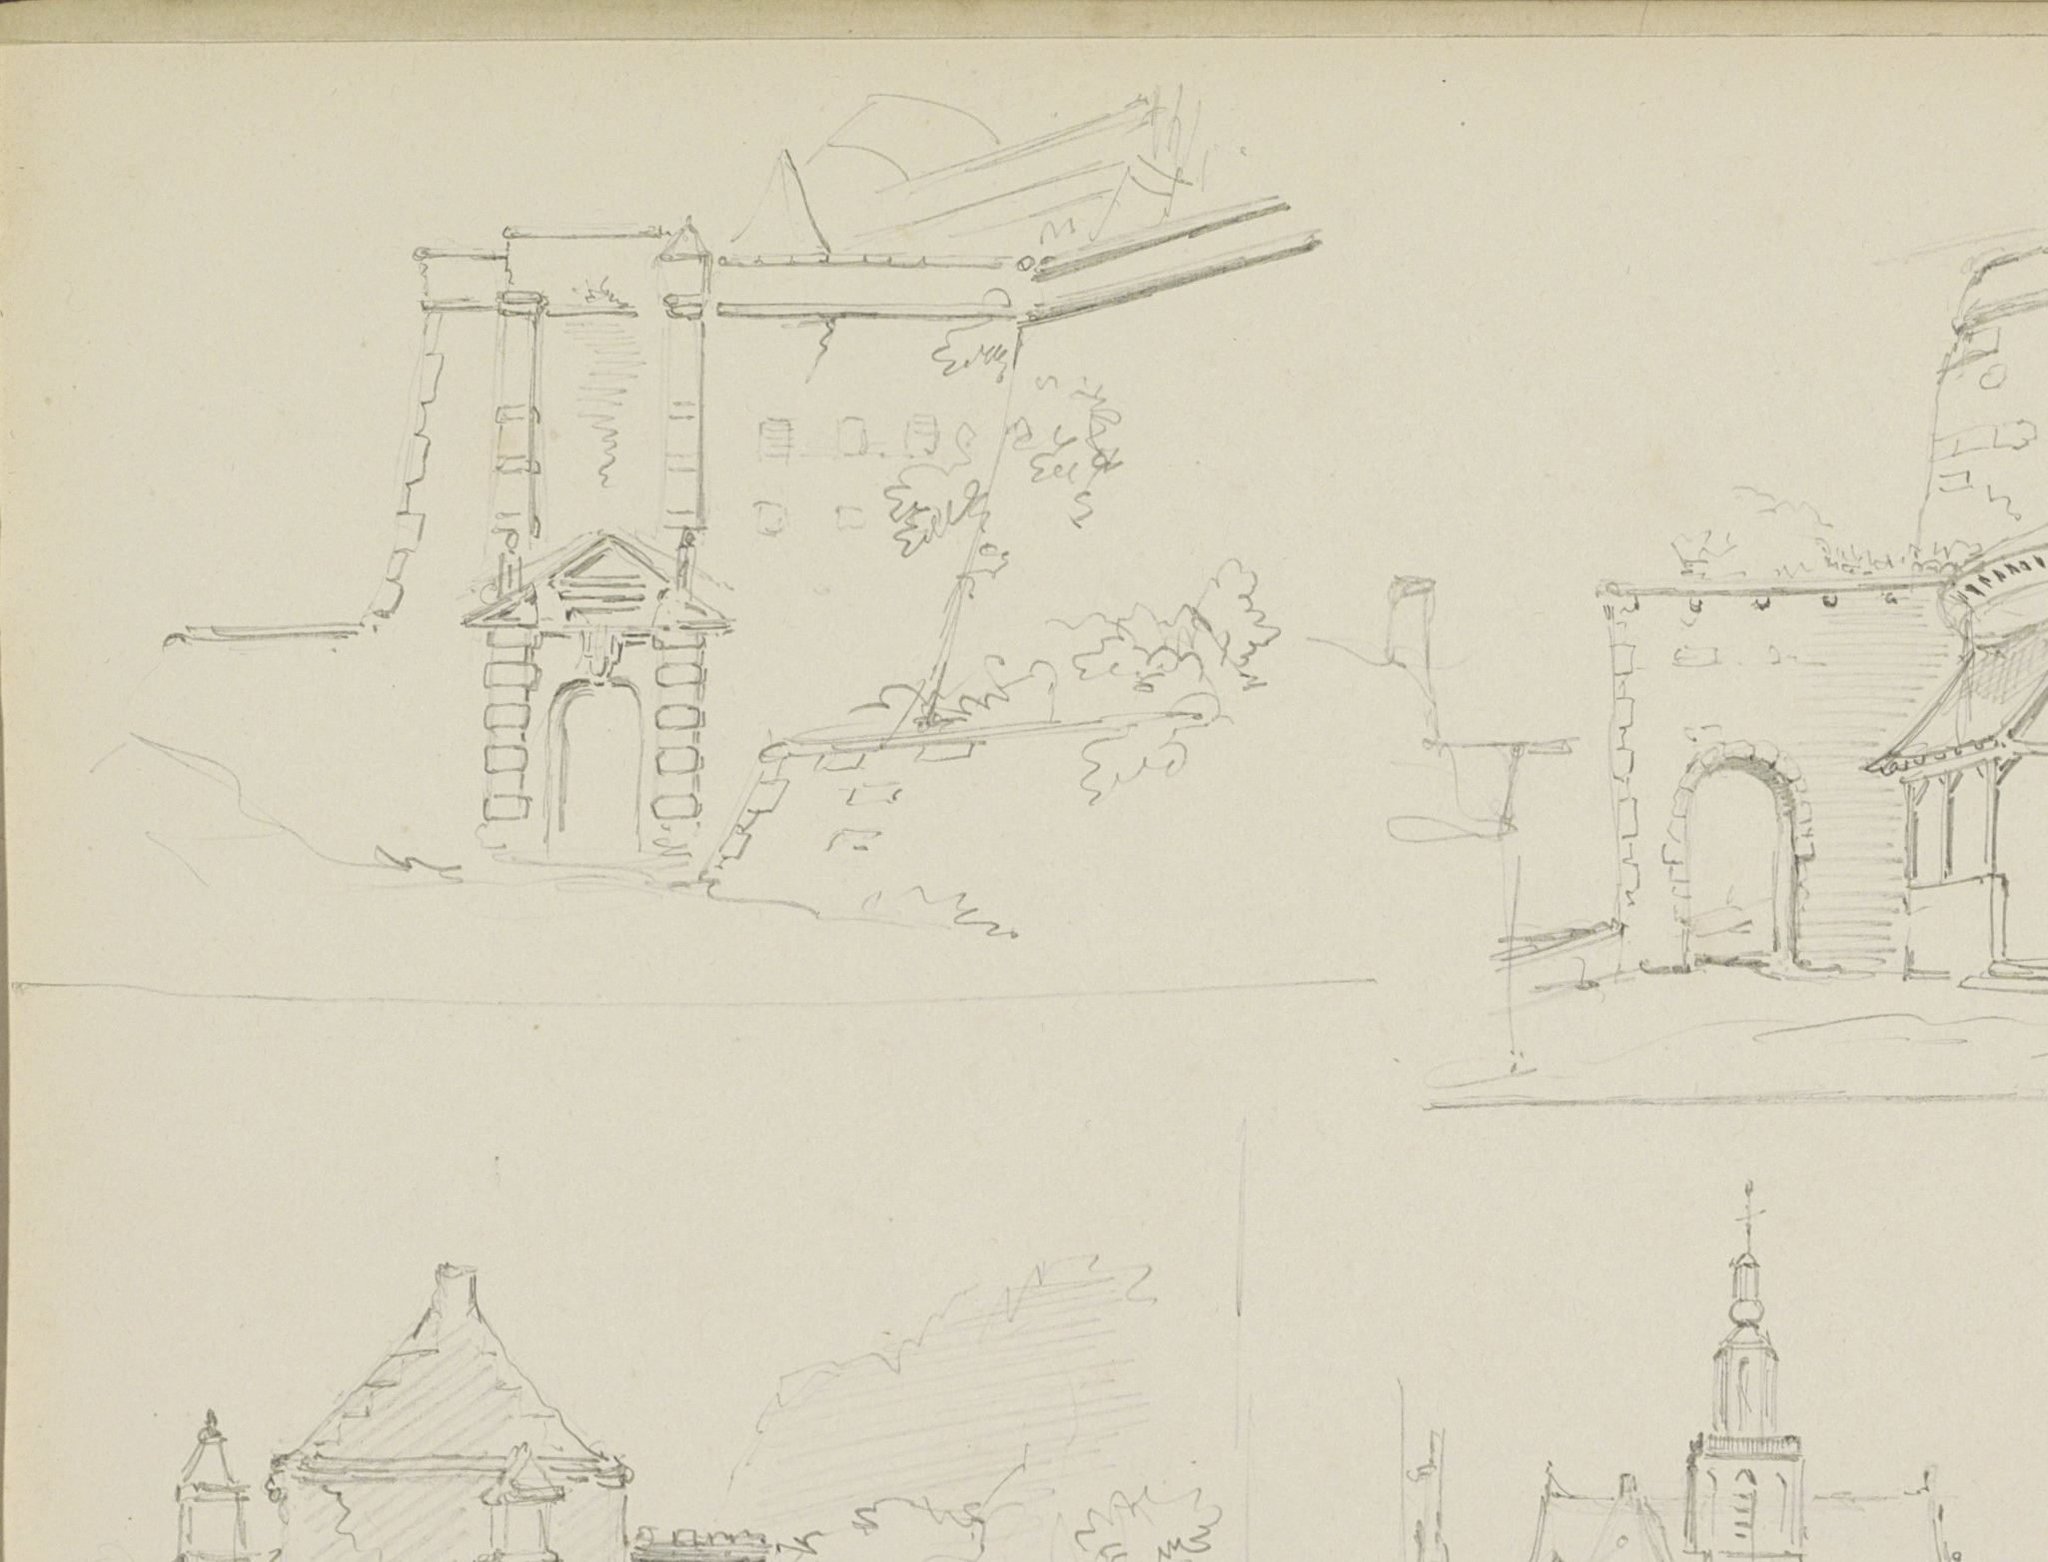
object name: sketchbook leaf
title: Vier gezichten op gebouwen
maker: adrianus eversen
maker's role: draughtsman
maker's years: 1818-1897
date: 1828-1897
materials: paper, pencil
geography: netherlands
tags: city-view, and landscape with man-made constructions, housing, church (exterior), gate, entrance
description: Vier gezichten op gebouwen. Linksboven een gezicht op een muur met een poort. Rechtsonder een stadsgezicht met een kerk. Blad 12 recto uit een schetsboek met 41 bladen.